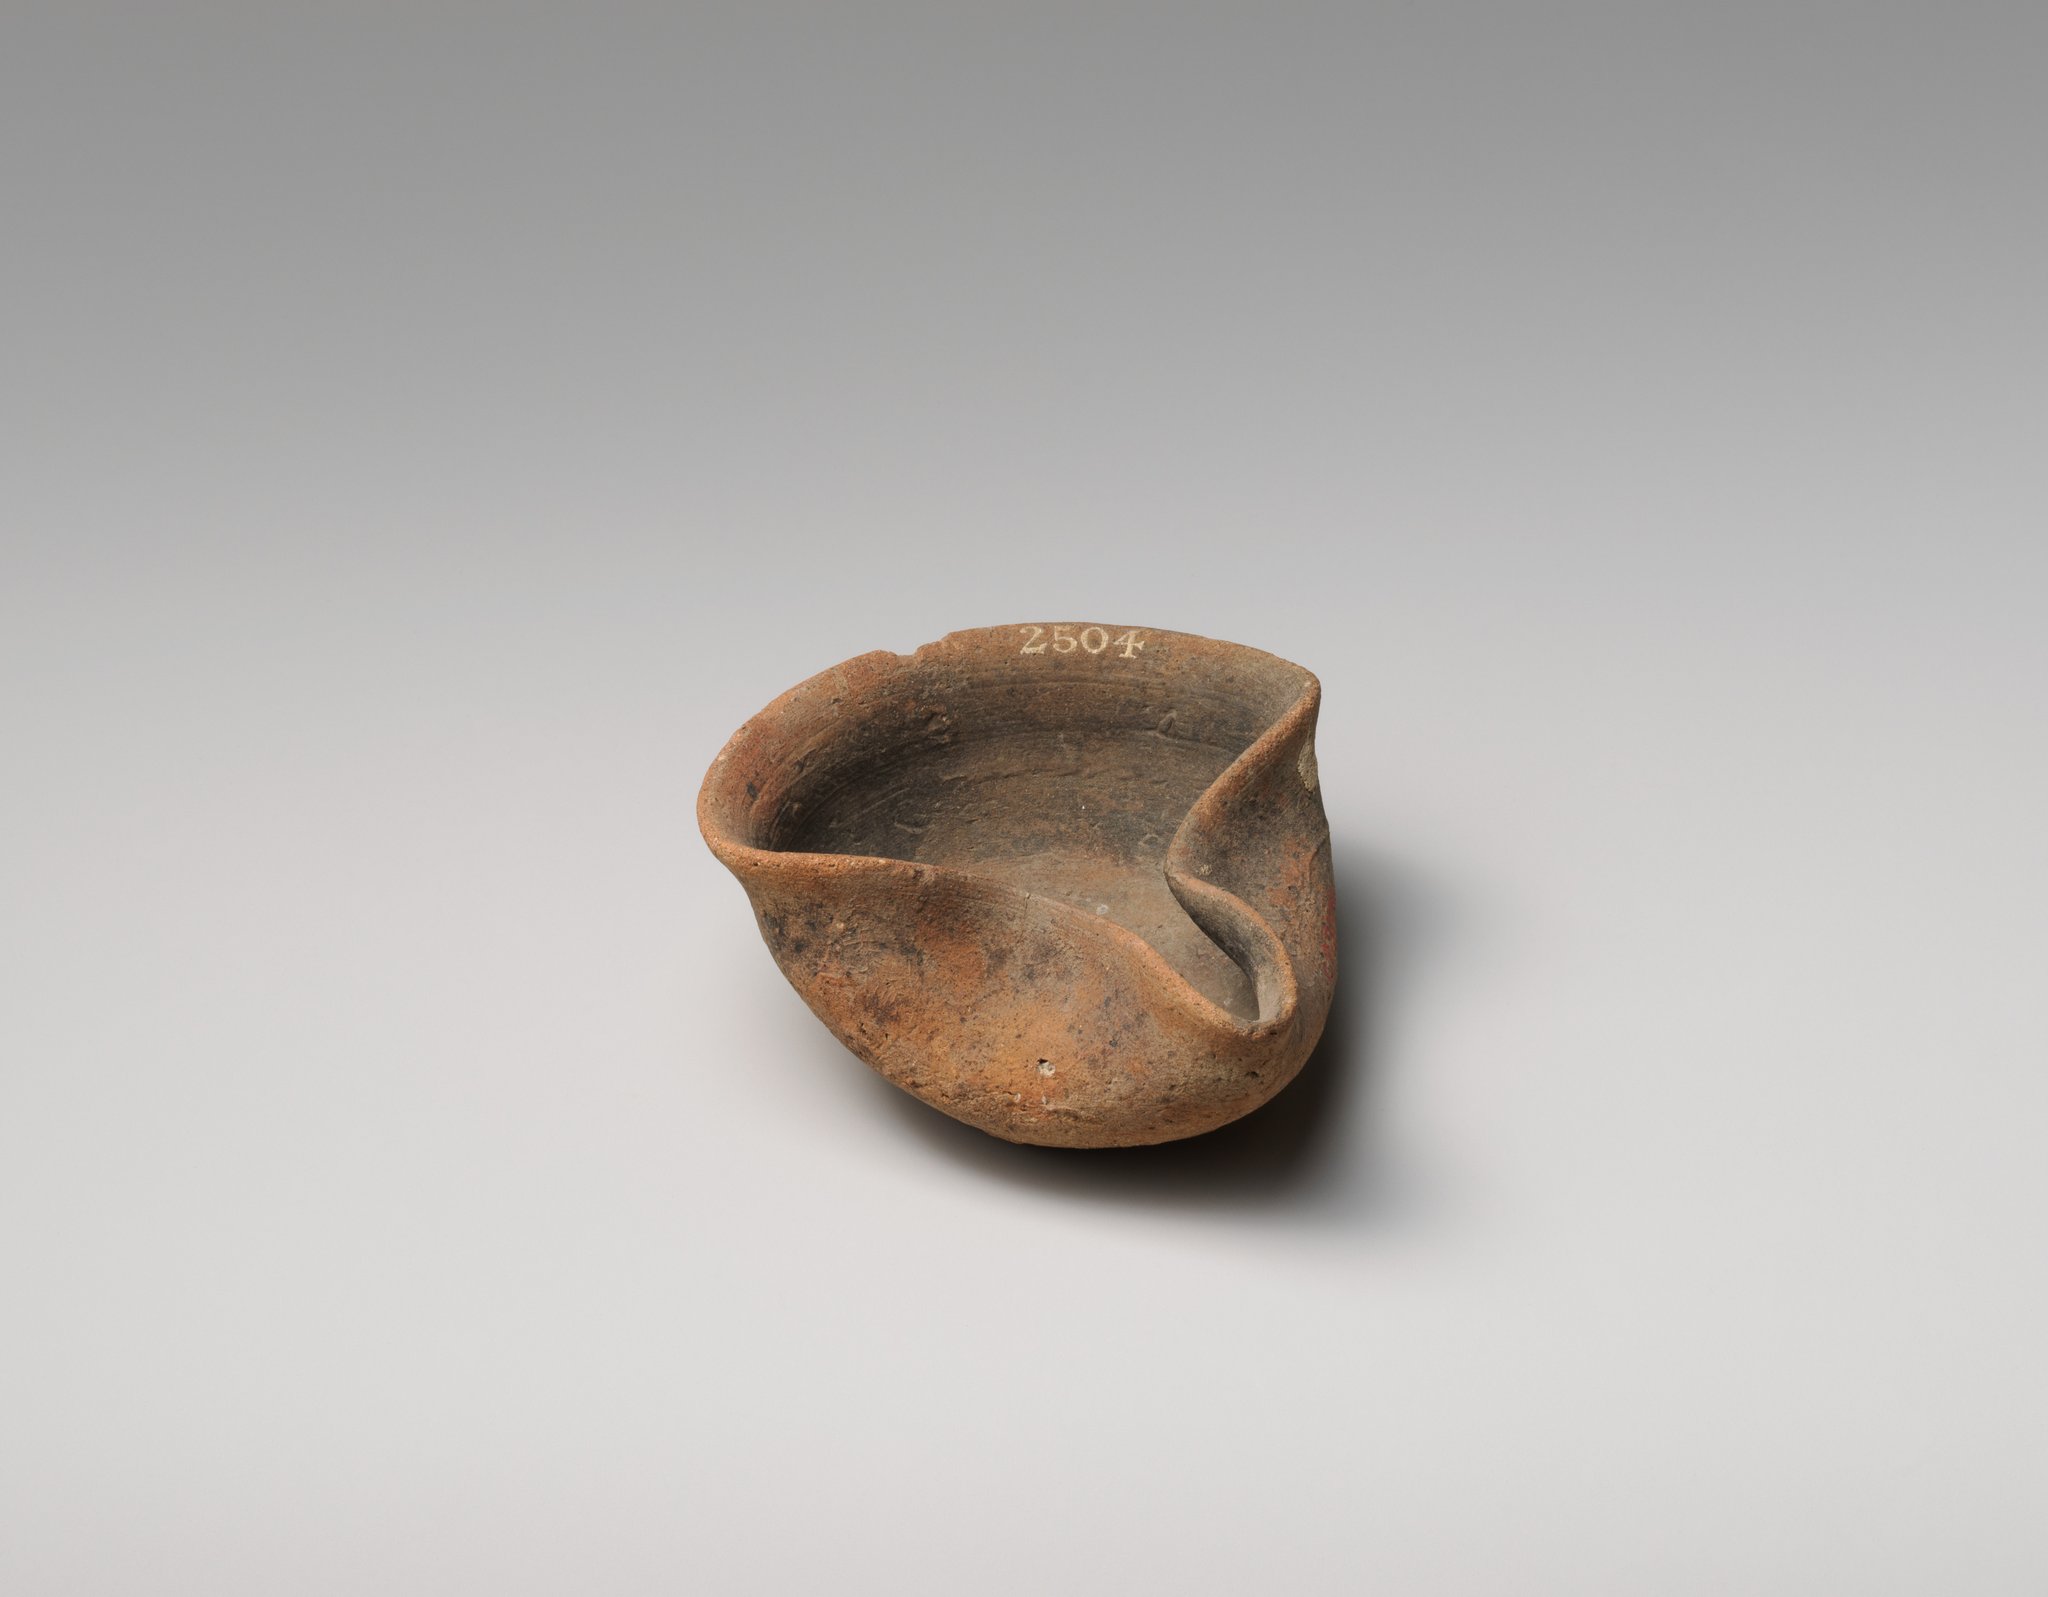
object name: lamp, saucer shaped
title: Terracotta saucer-shaped lamp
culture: cypriot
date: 400-301 BCE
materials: terracotta